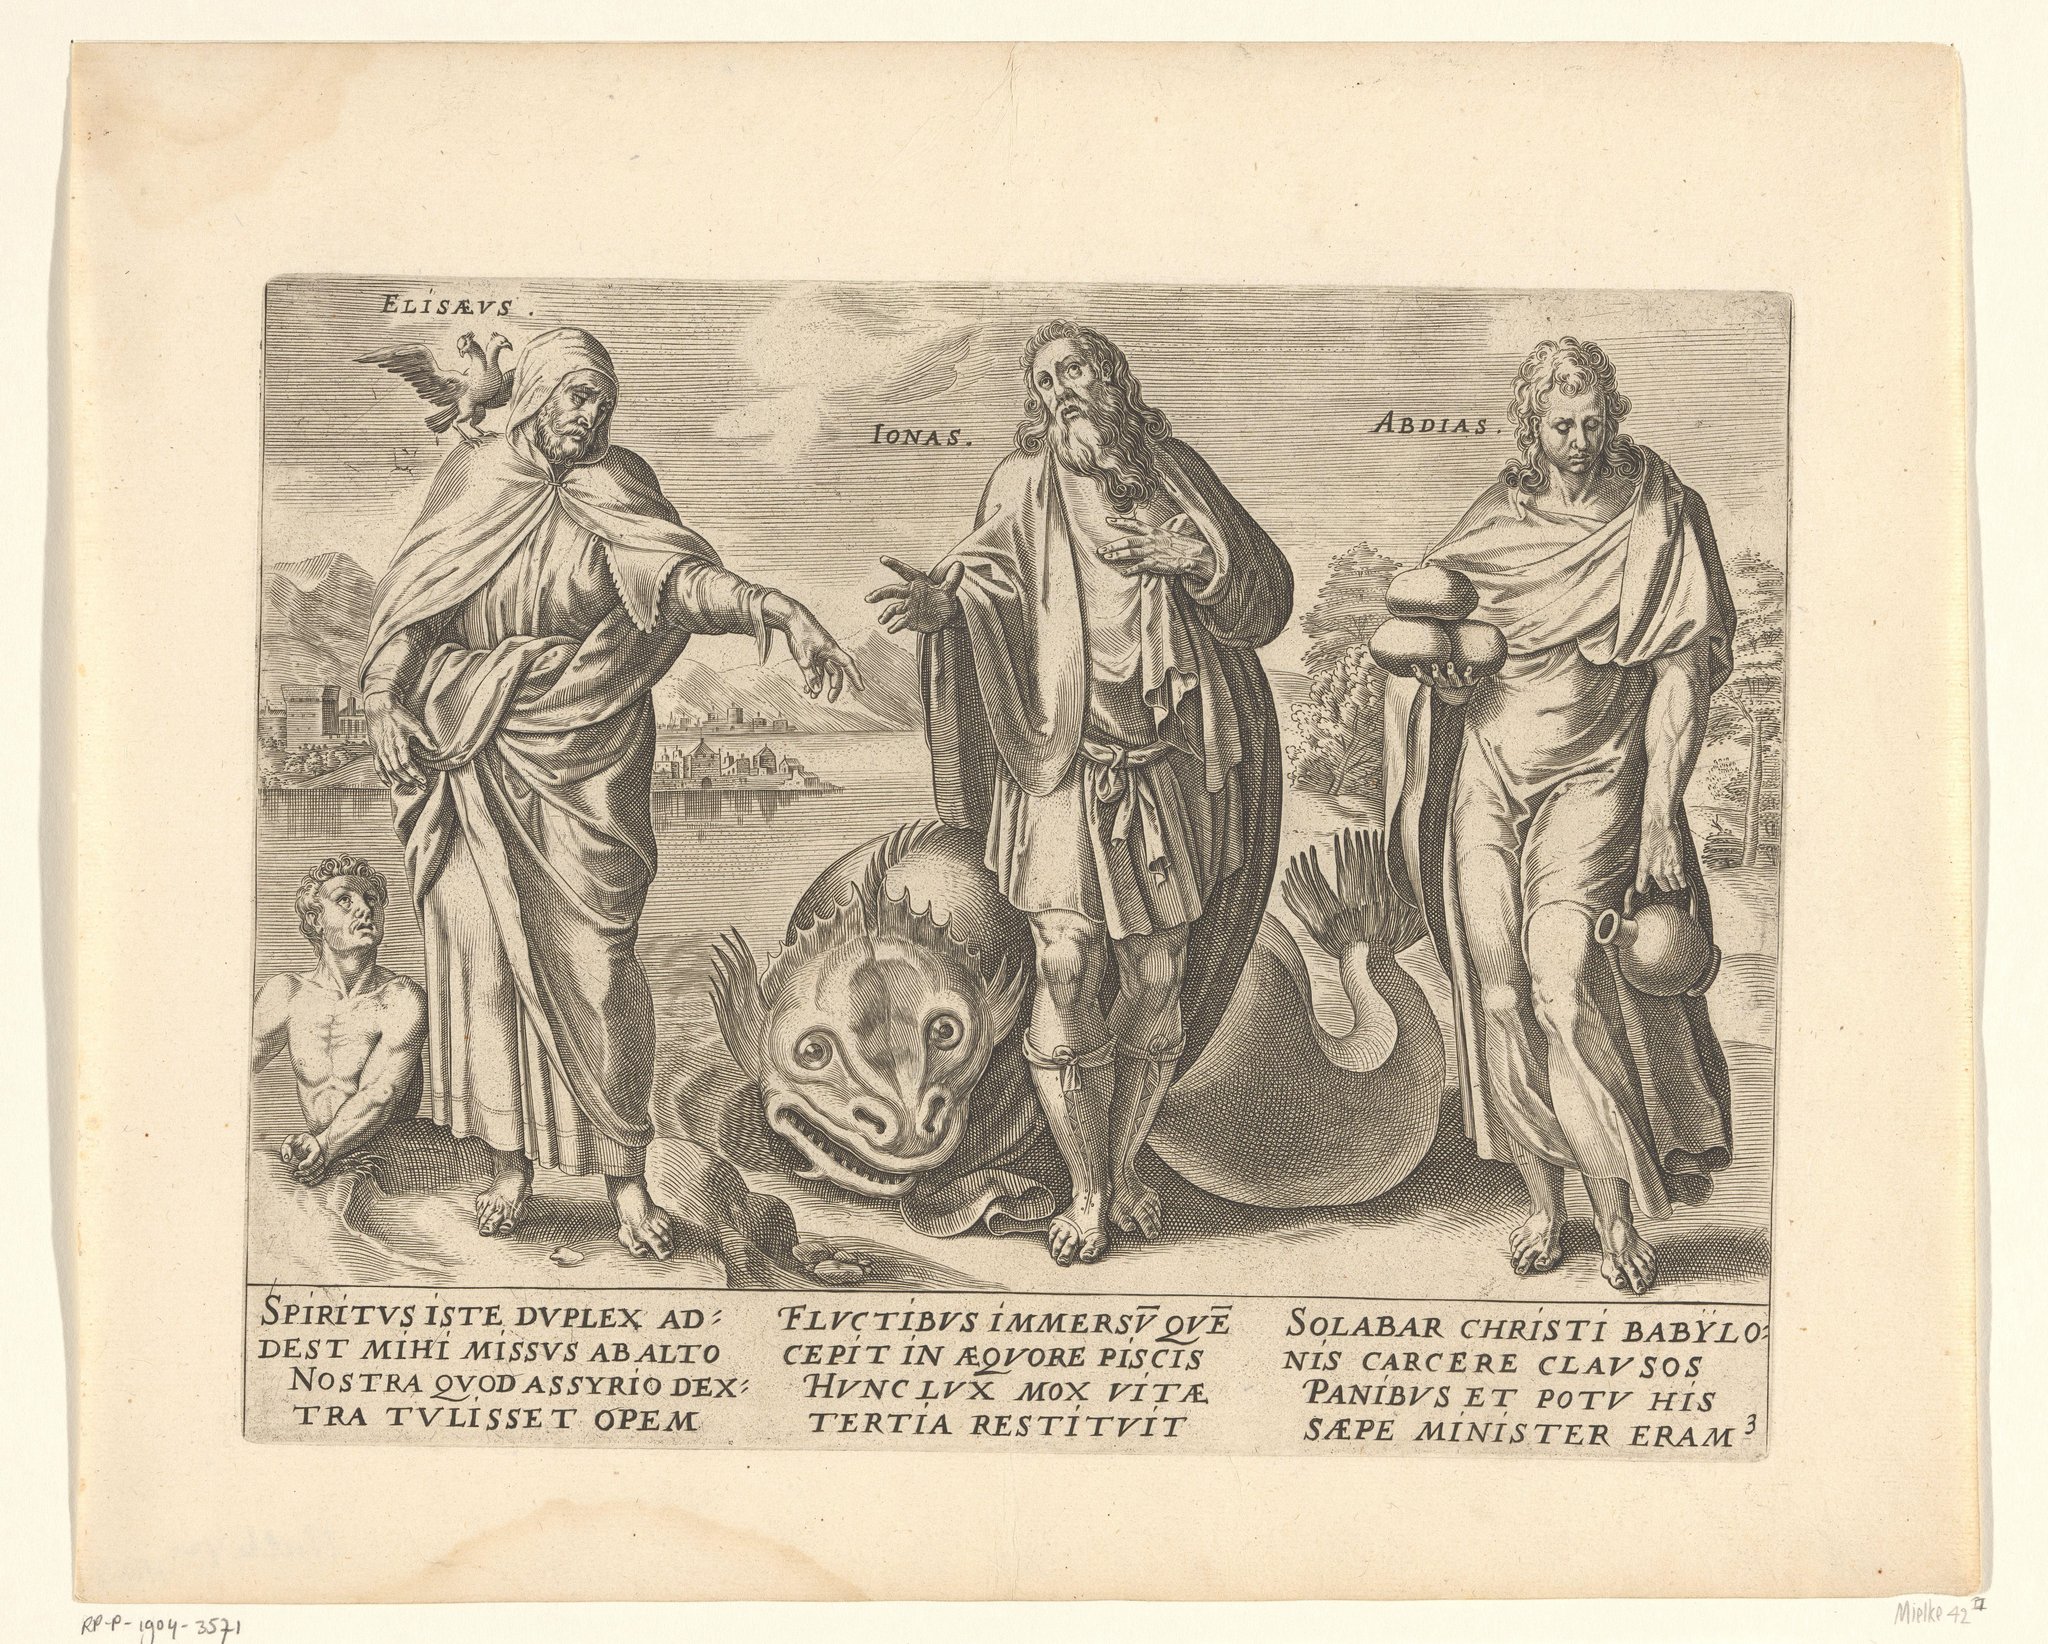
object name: print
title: Theatrum biblicum (...)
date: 1579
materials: paper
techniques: engraving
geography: amsterdam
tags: story of elisha (eliseus), the book of jonah, the four major prophets (not in biblical context): isaiah, jeremiah, ezekiel, daniel, the book of obadiah, naaman comes to the jordan, dips himself seven times and is cured, swimming mammals: whale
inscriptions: collector's mark: Lugt 2228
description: De profeten Elisa, Jona en Obadja staan naast elkaar in een landschap. Elisa heeft een tweekoppige vogel op de schouder staan en staat naast Naäman, die op Elisa's advies zich baadt in de Jordaan. Jona staat naast de vis, Obadja heeft drie broden en een kruik in zijn handen. Onder de voorstelling toelichtingen in het Latijn.